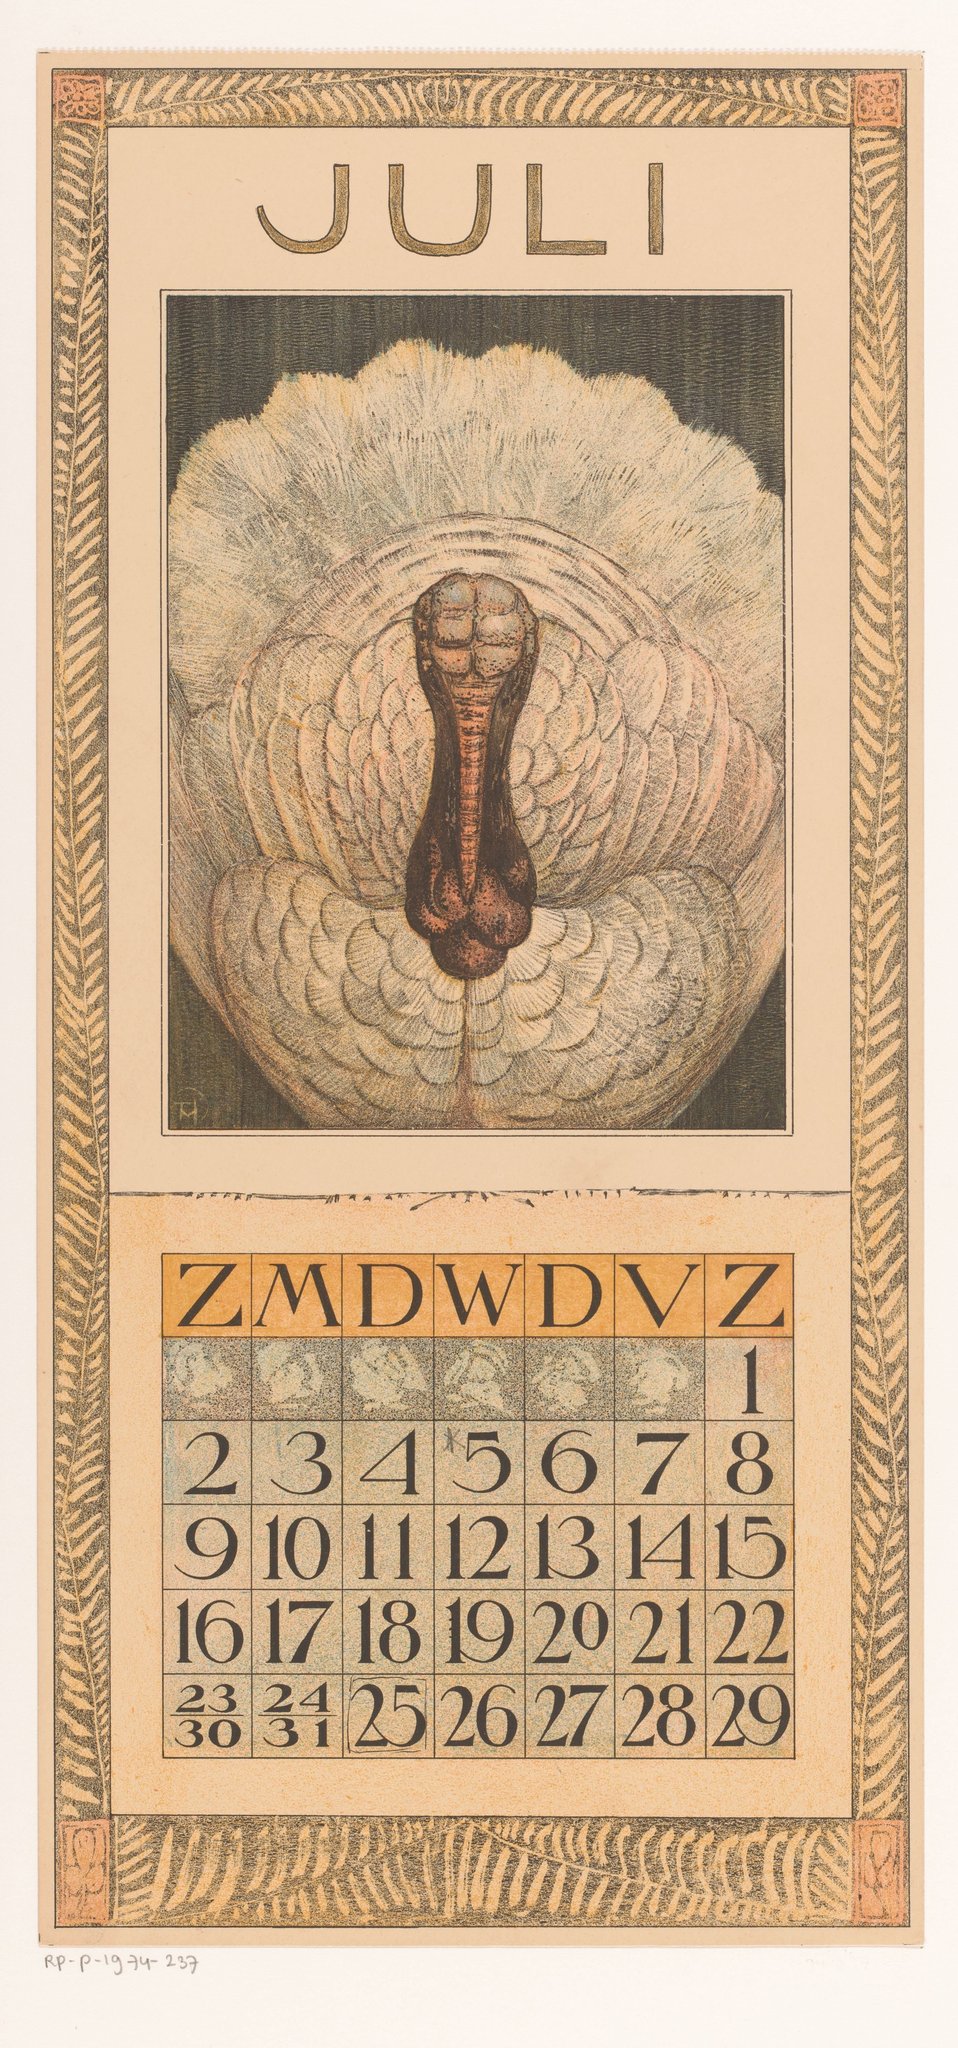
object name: calendar leaf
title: Kalenderblad juli met kalkoen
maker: theo van hoytema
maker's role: draughtsman, painter, print maker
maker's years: 1863-1917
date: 1904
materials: paper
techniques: lithograph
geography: amsterdam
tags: walker and runner birds: turkey, july ~ other concepts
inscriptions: collector's mark: Lugt 2228